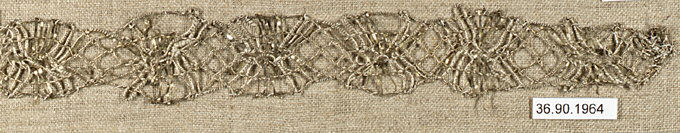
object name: piece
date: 1701-1800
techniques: lace